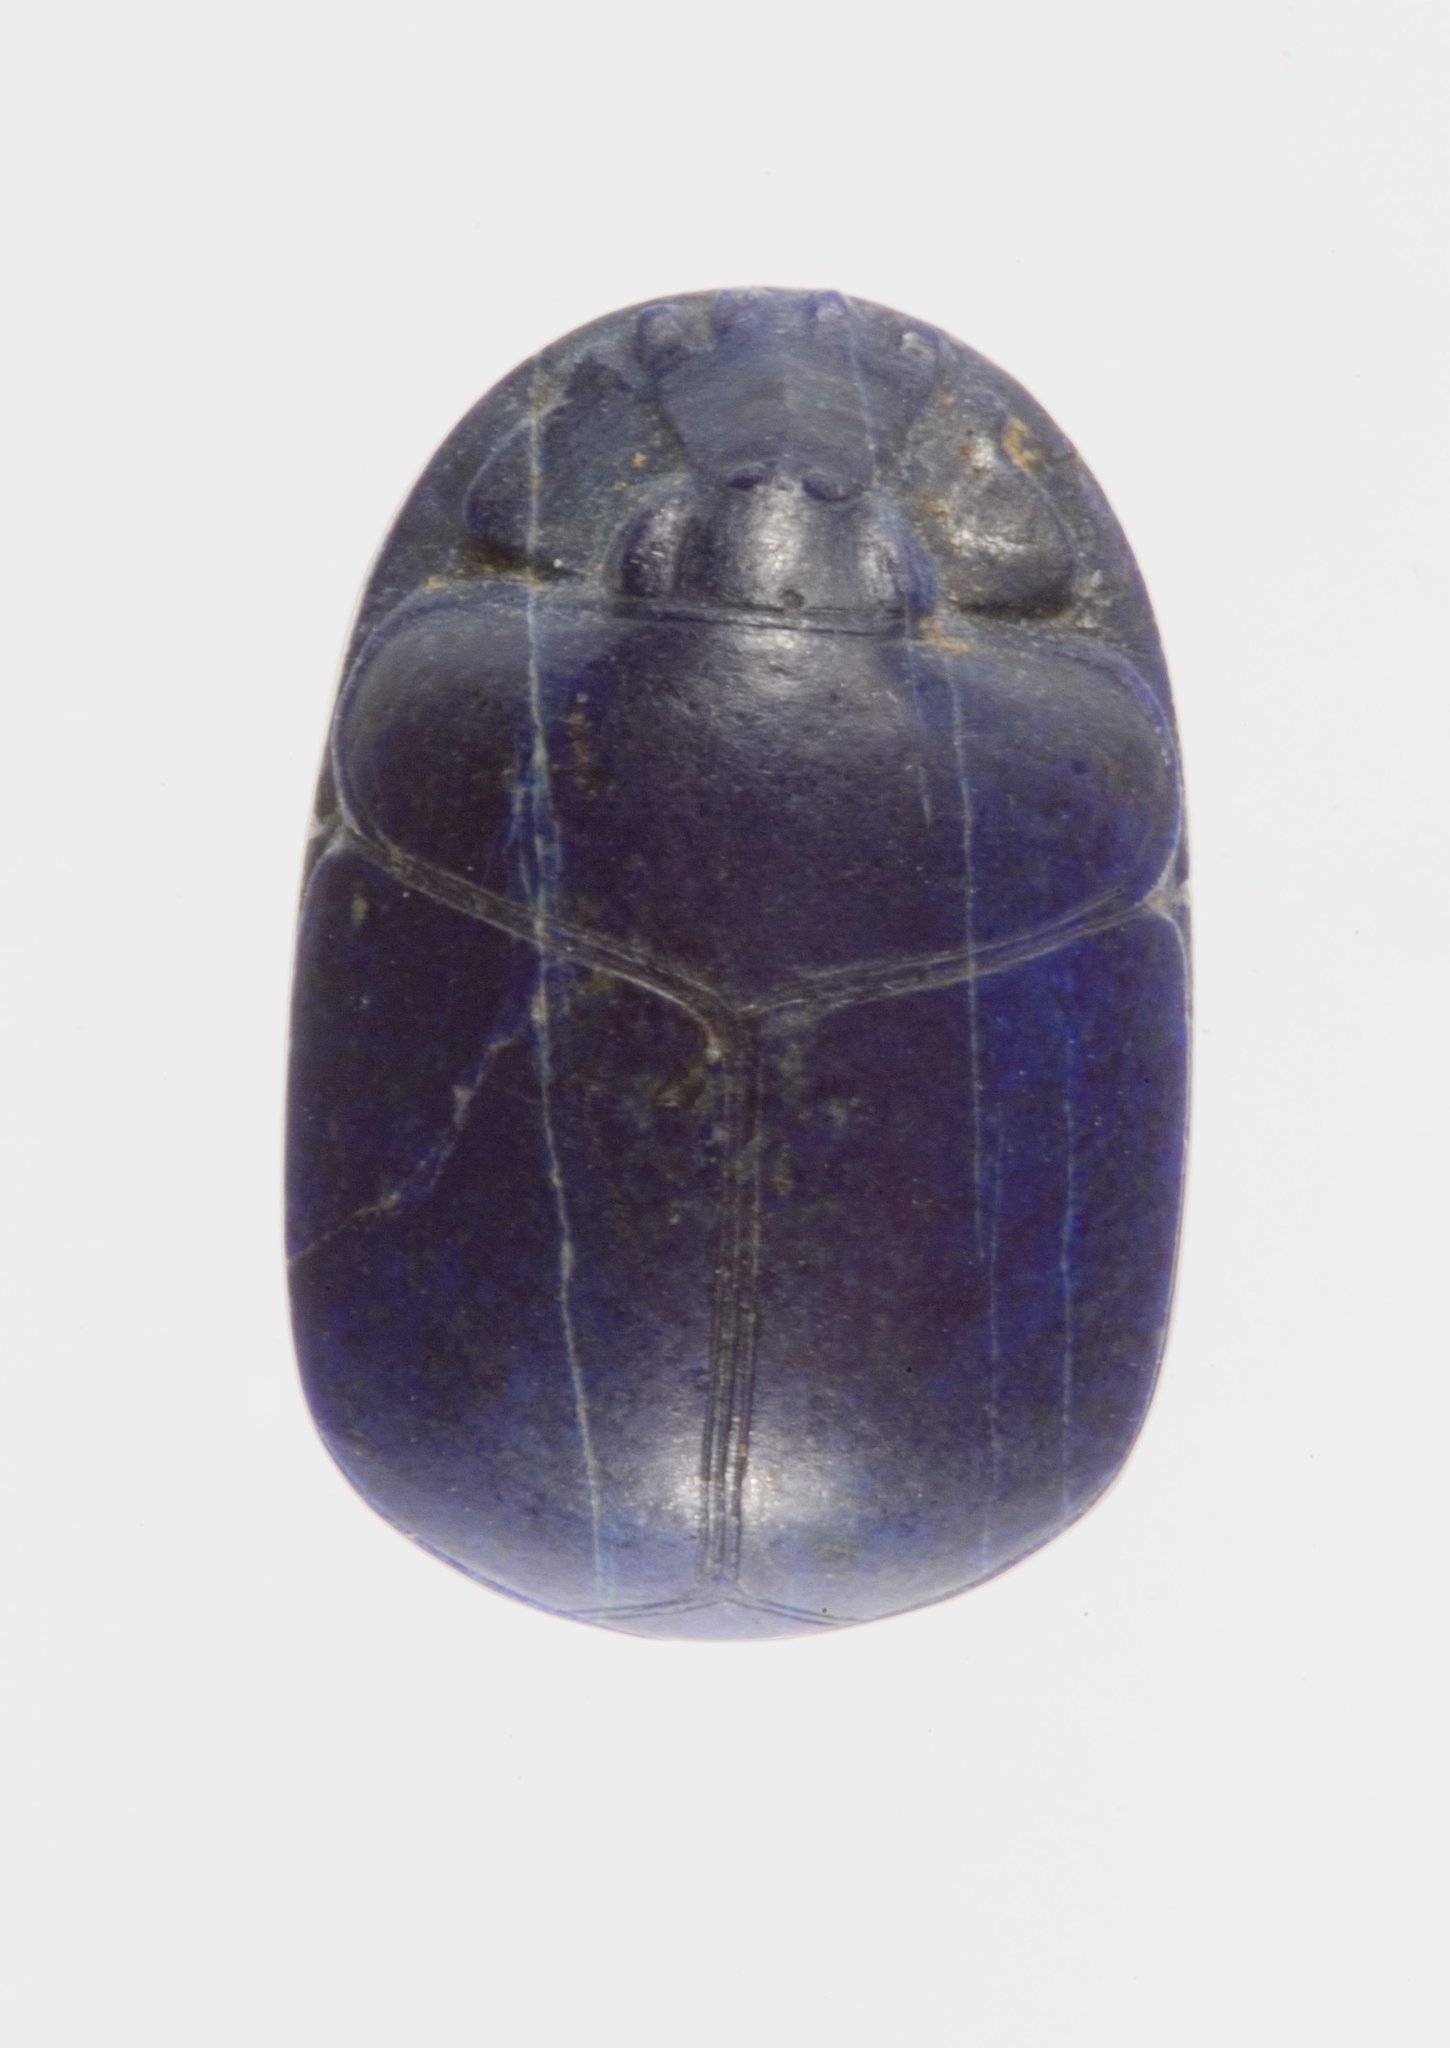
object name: scarab, sithathoryunet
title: Uninscribed Scarab of Sithathoryunet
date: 1887-1813 BCE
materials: lapis lazuli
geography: egypt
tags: scarabs